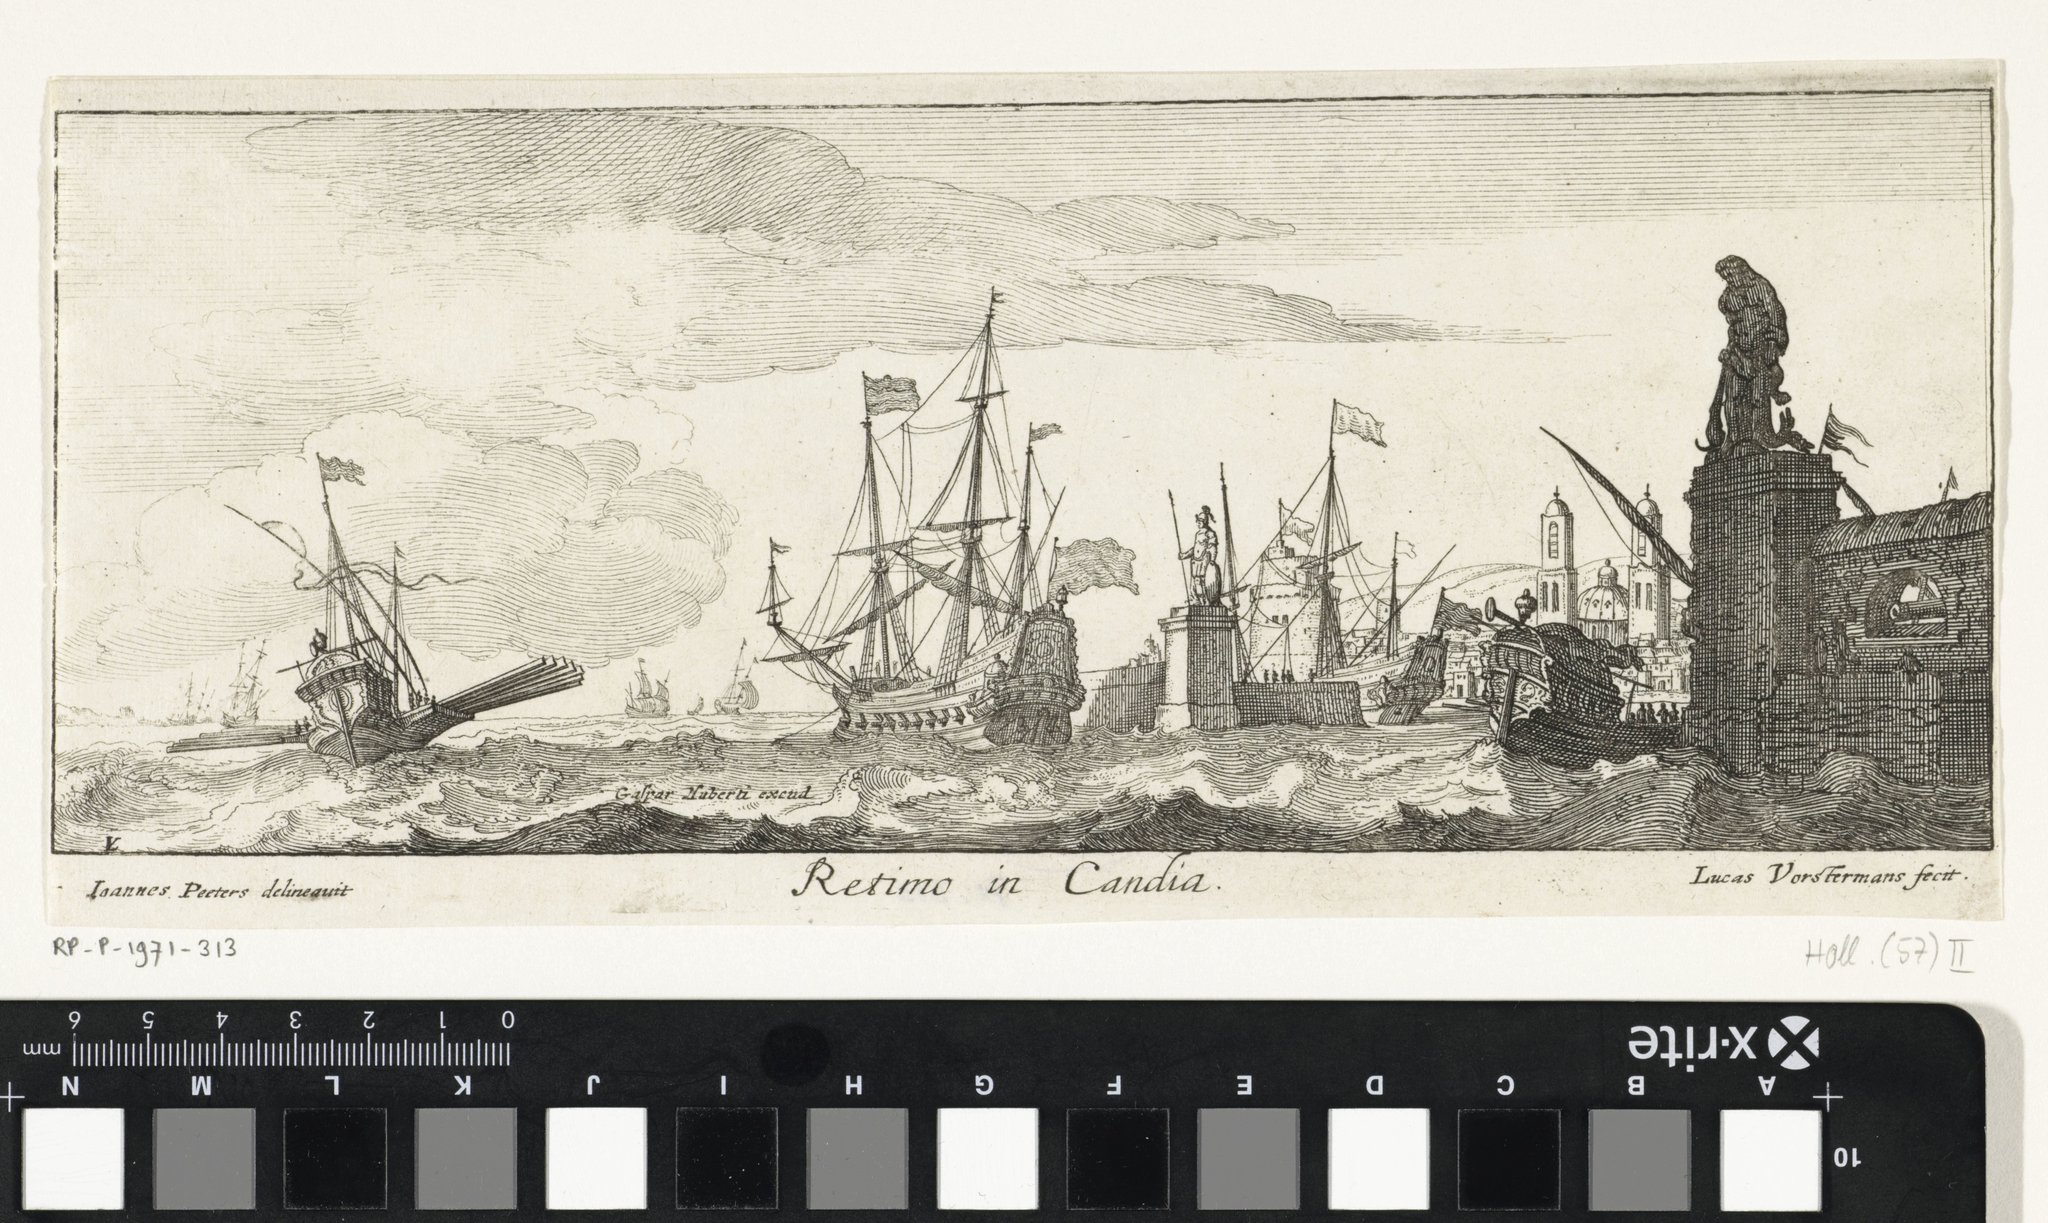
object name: print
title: Topografische gezichten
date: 1683-1684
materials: paper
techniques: etching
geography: antwerp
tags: harbour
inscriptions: collector's mark: Lugt 2228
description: Prent gebruikt in: Description des principales villes, havres et isles du golfe de Venise du cote oriental, comme aussi des villes et fortresses de la Moree et quelques places de la Grece et es isles principales de l'Archipel et fortresses dícelles et en suittes quelques places renommées de la Terre Saincte, et autres dessous la domination Ottomane vers le Midij et l'Orient, et quelques principales villes en Perse et le regne du Grand Mogol le tout en Abrege. Antwerpen: Jacob Peeters, s.a.